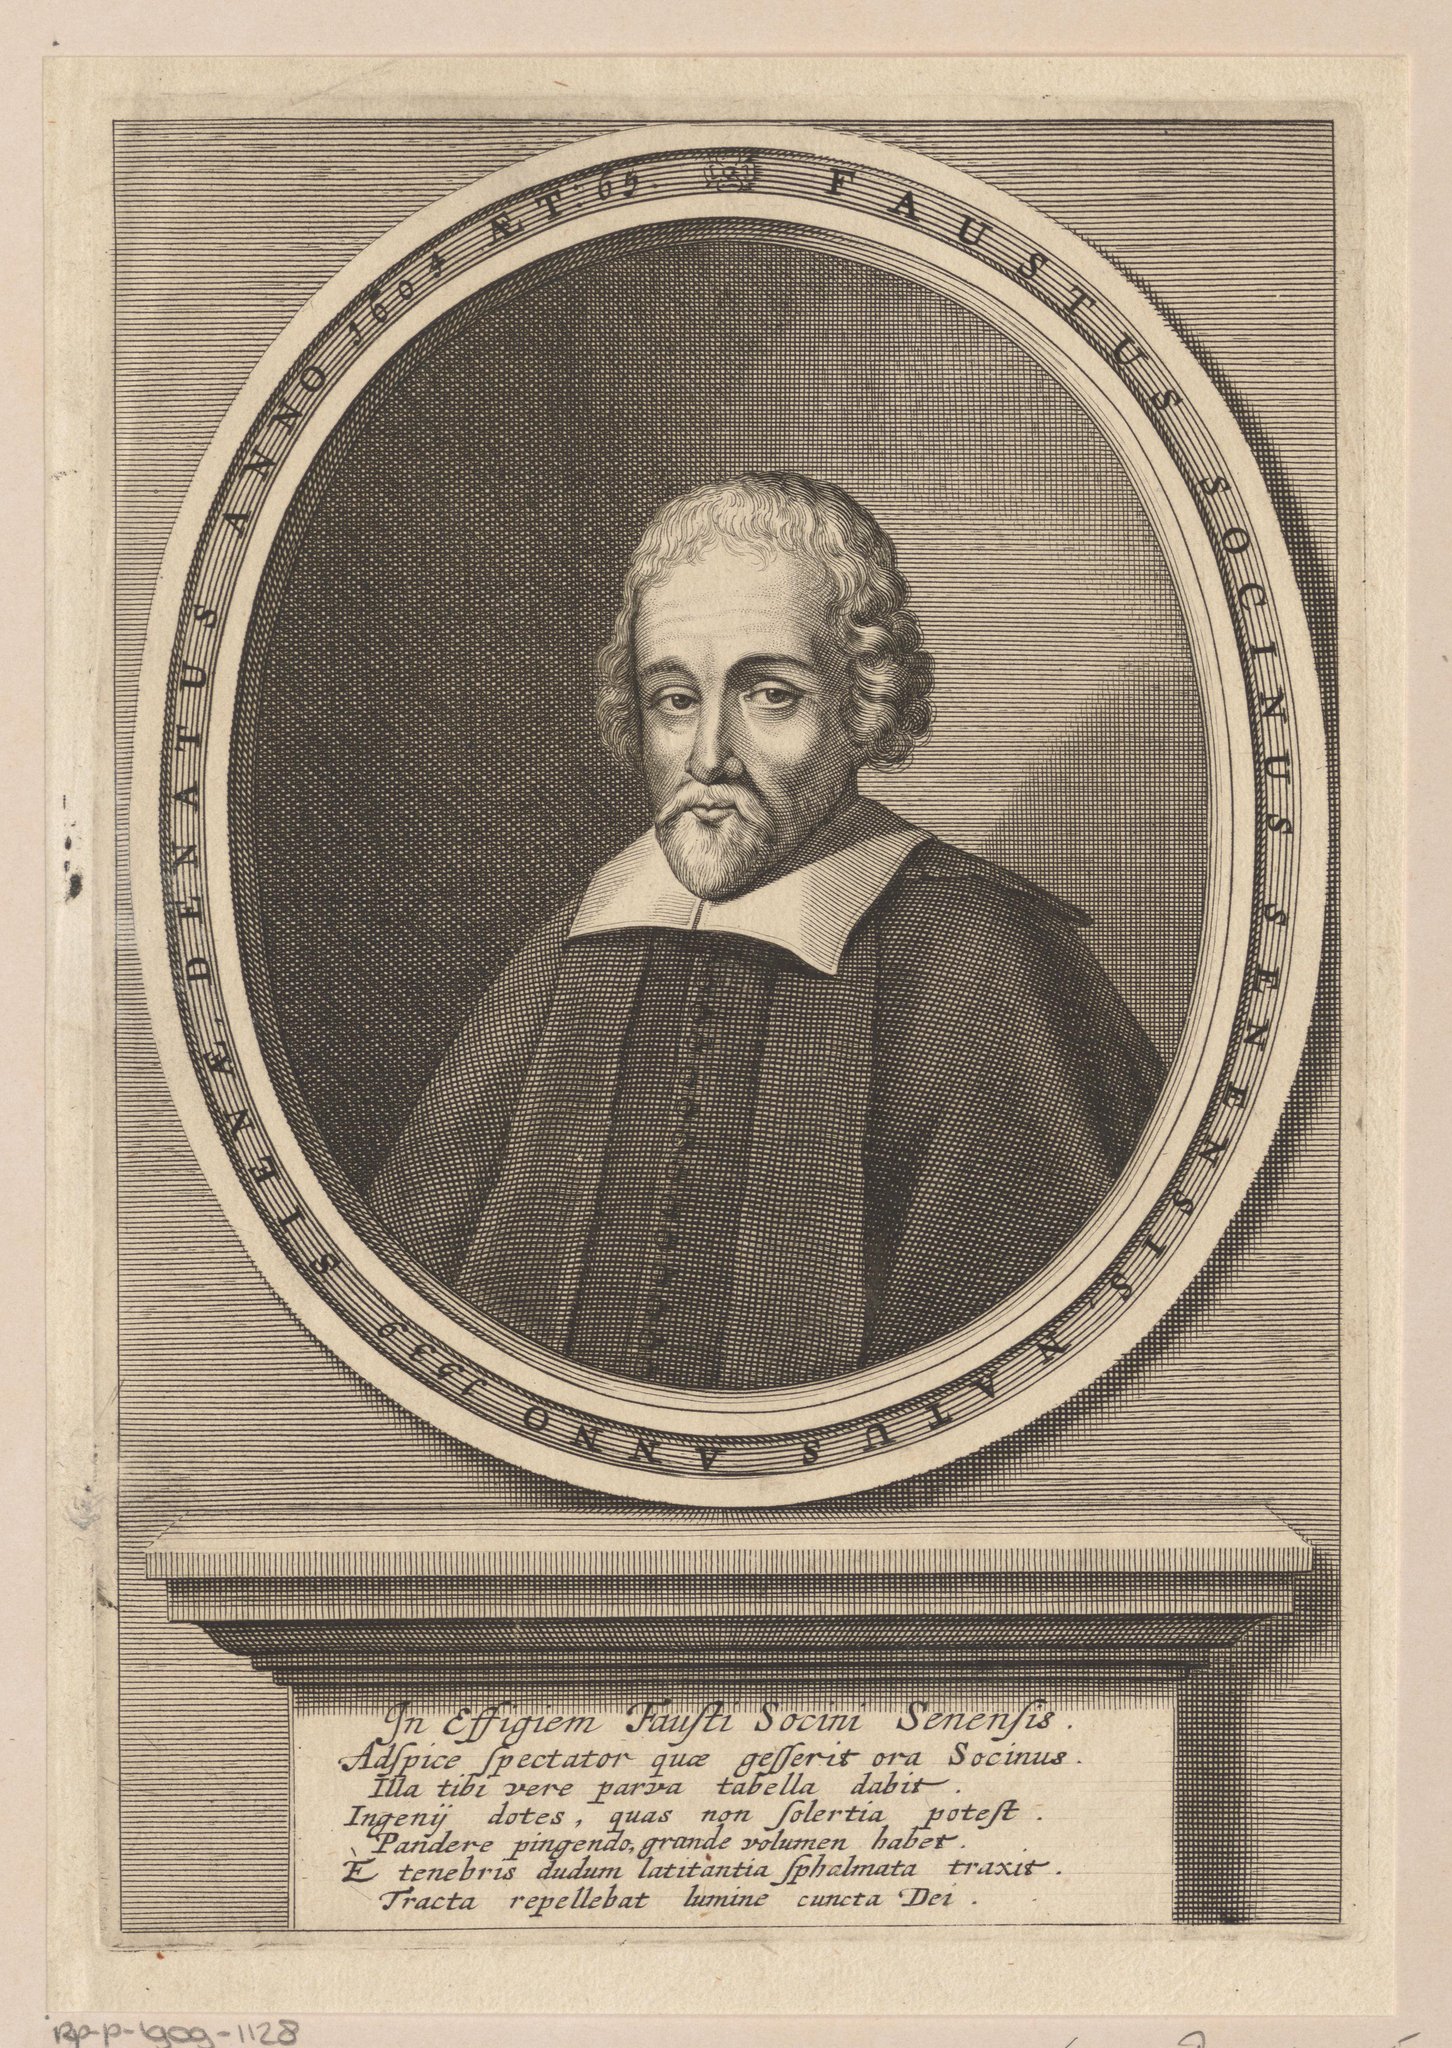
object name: print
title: Portret van Faustus Socinus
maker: lambert visscher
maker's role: draughtsman, print maker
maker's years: 1640-1679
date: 1656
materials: paper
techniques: engraving, etching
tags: theologian, historical persons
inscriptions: collector's mark: Lugt 2228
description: Prent waarschijnlijk uit: Socinus, Faustus. Senensis Opera omnia in duos tomos distincta (...). Irenopolis: s.n., 1656.